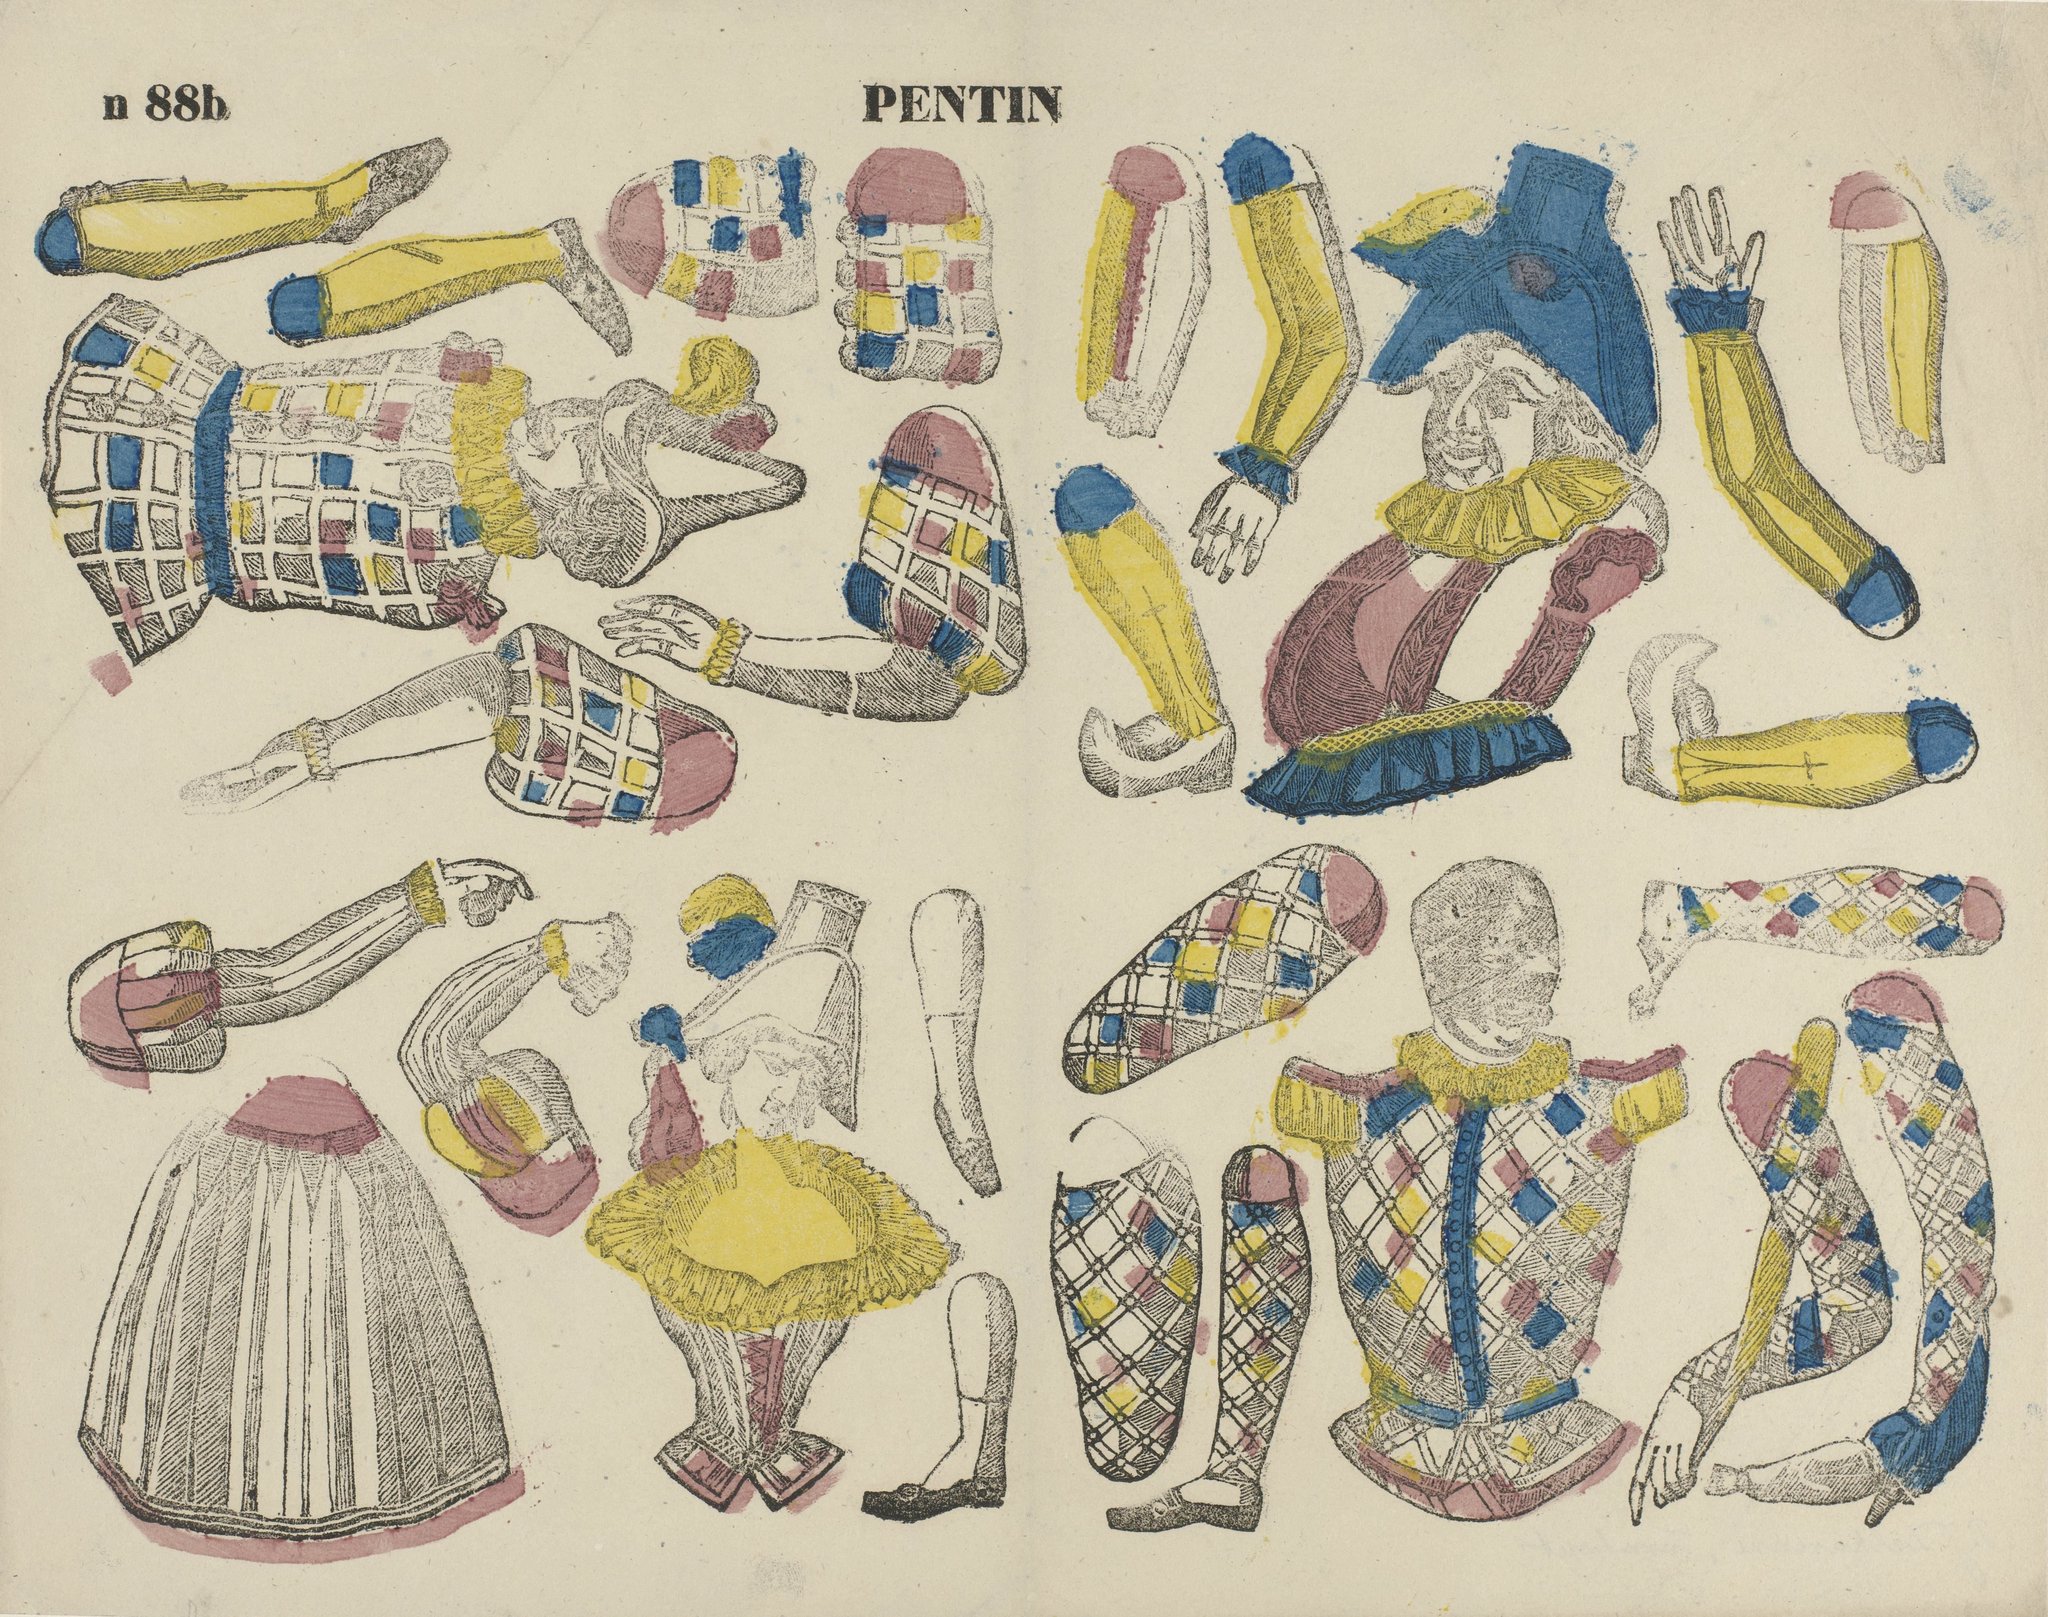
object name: print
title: Pentin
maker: Anonymous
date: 1834-1842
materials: paper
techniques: colour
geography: turnhout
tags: puppet, types in 'commedia dell'arte': harlequin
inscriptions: collector's mark: Lugt 2760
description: Blad met 4 trekpoppen om uit te knippen. De vier poppen zijn personages uit de commedia dell'arte. Genummerd linksboven: n 88b.